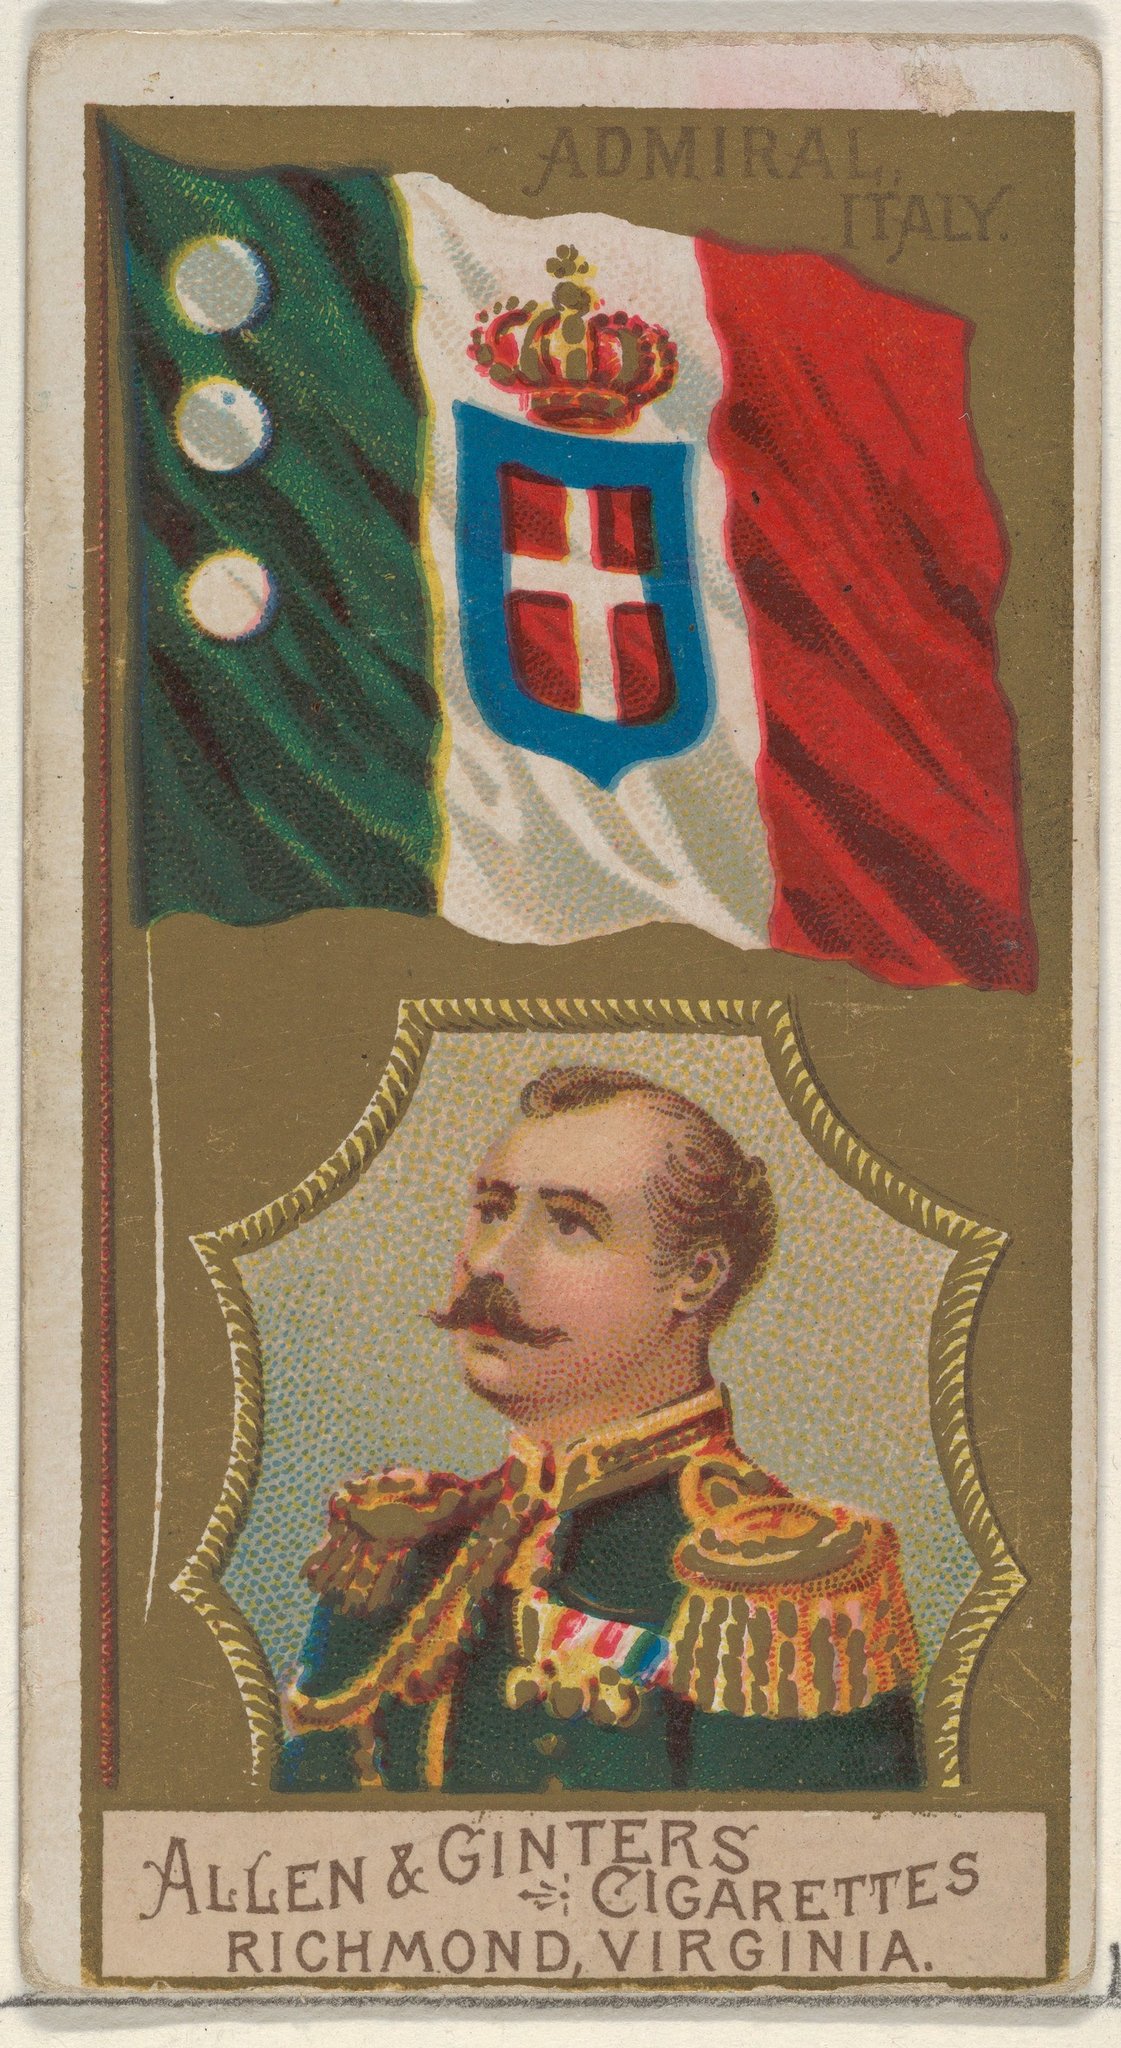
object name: print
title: Admiral, Italy, from the Naval Flags series (N17) for Allen & Ginter Cigarettes Brands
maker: allen & ginter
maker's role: publisher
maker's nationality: american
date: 1888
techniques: color lithograph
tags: men,flags